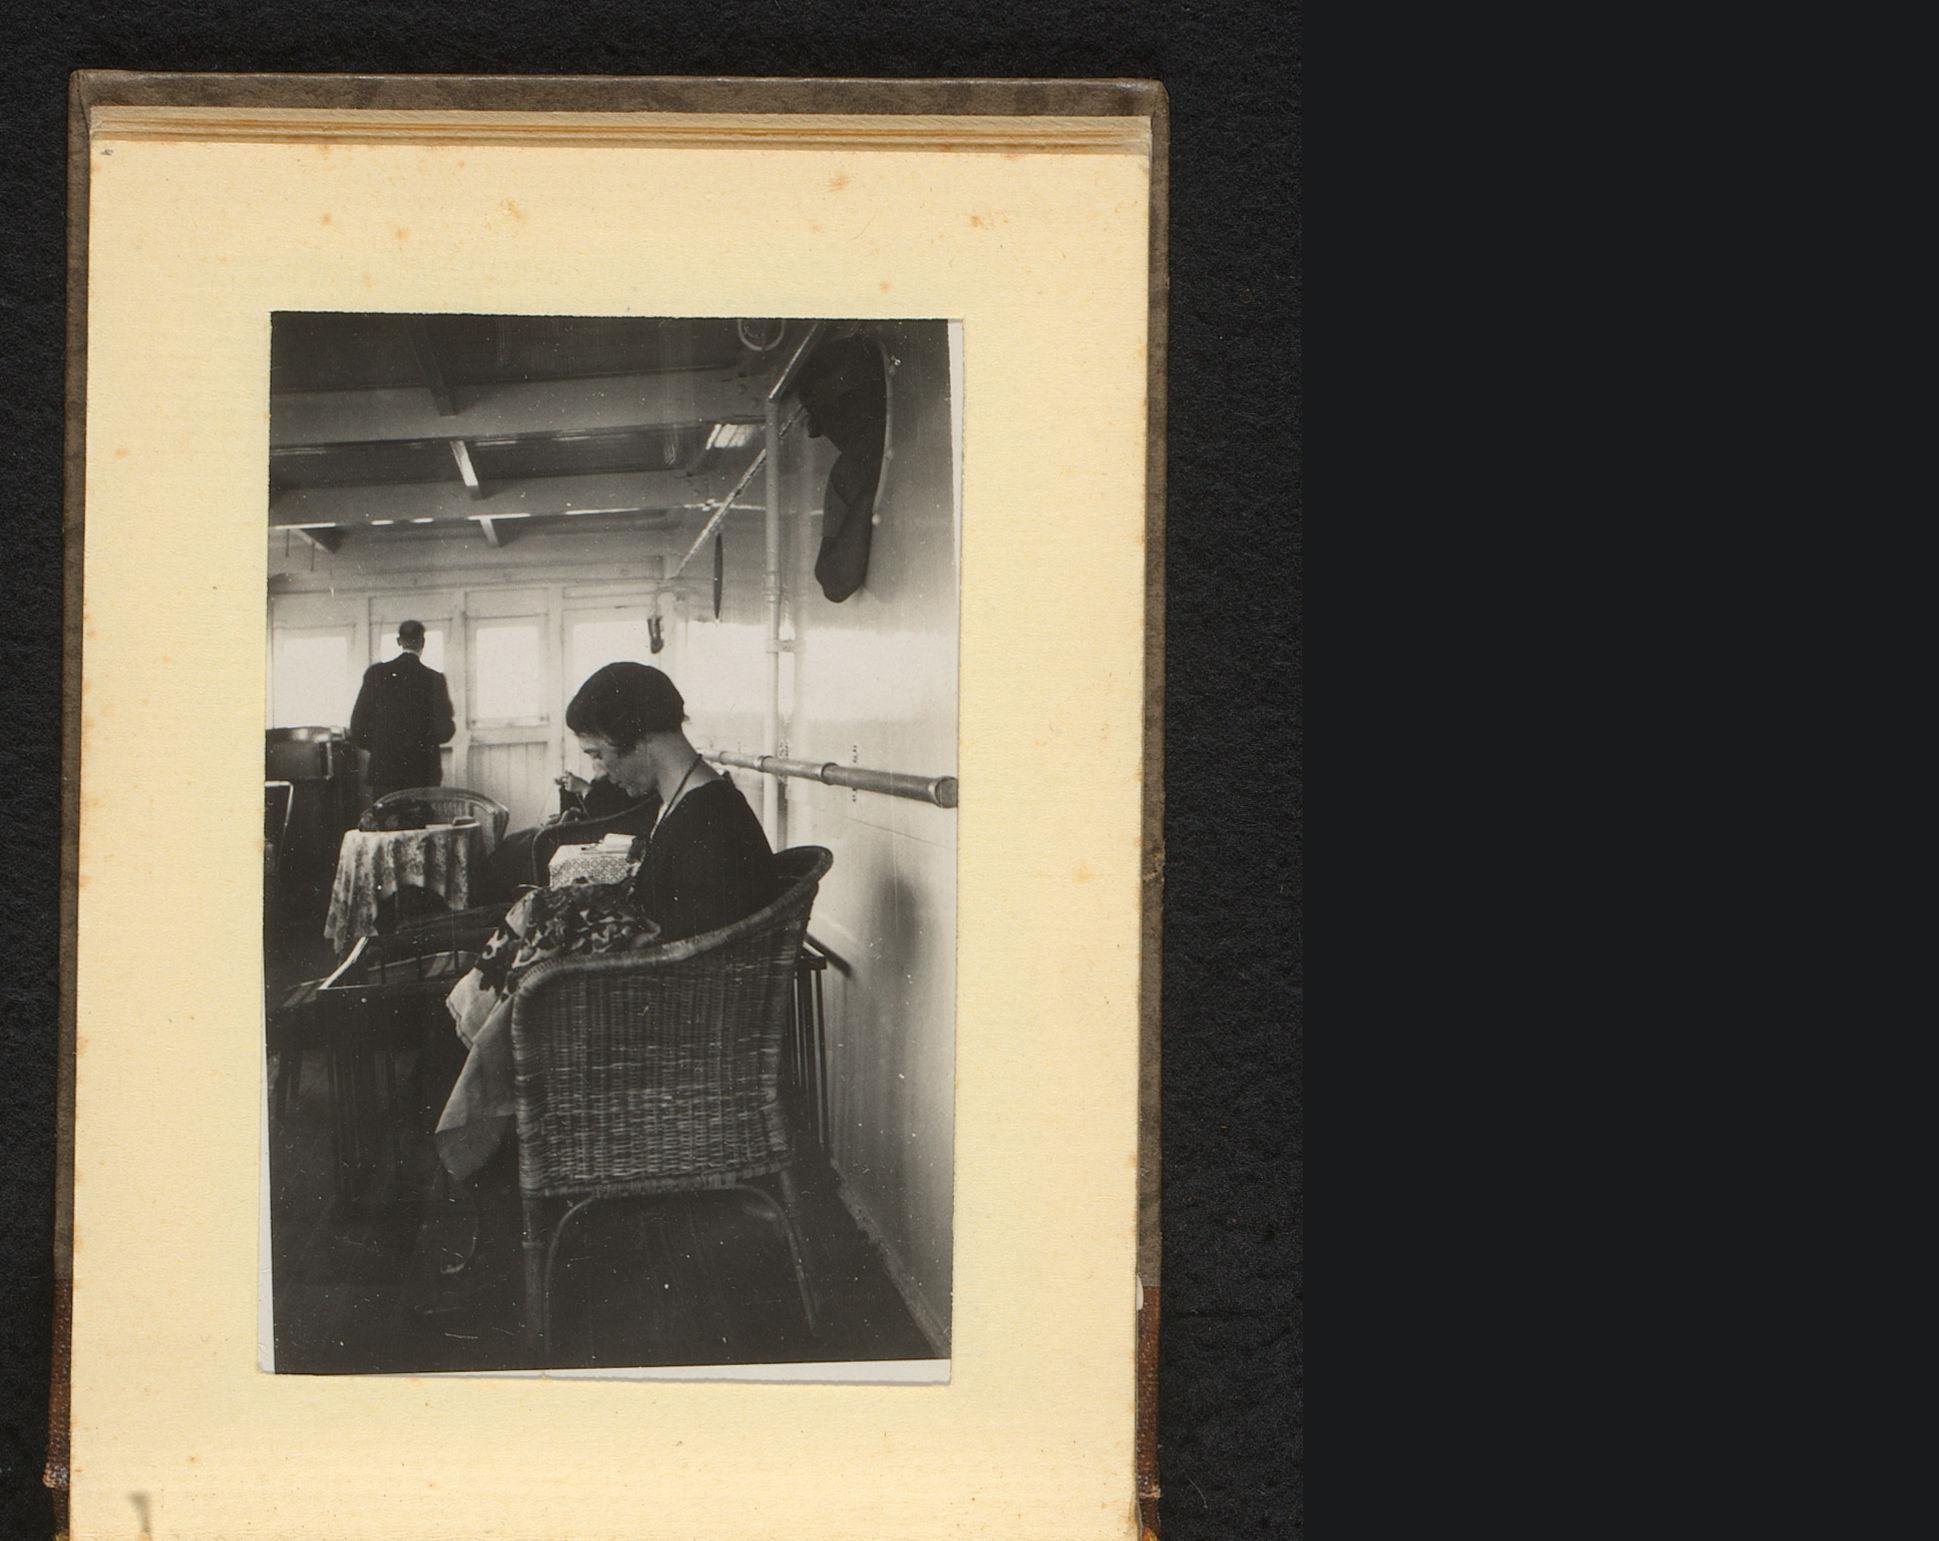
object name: album leaf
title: Zittende vrouw aan boord van een schip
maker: norbert van den berg (1901-1972)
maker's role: amateurfotograaf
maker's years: 1901-1972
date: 1935-1950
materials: paper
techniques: gelatin silver print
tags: sitting figure, adult woman, ships (in general)